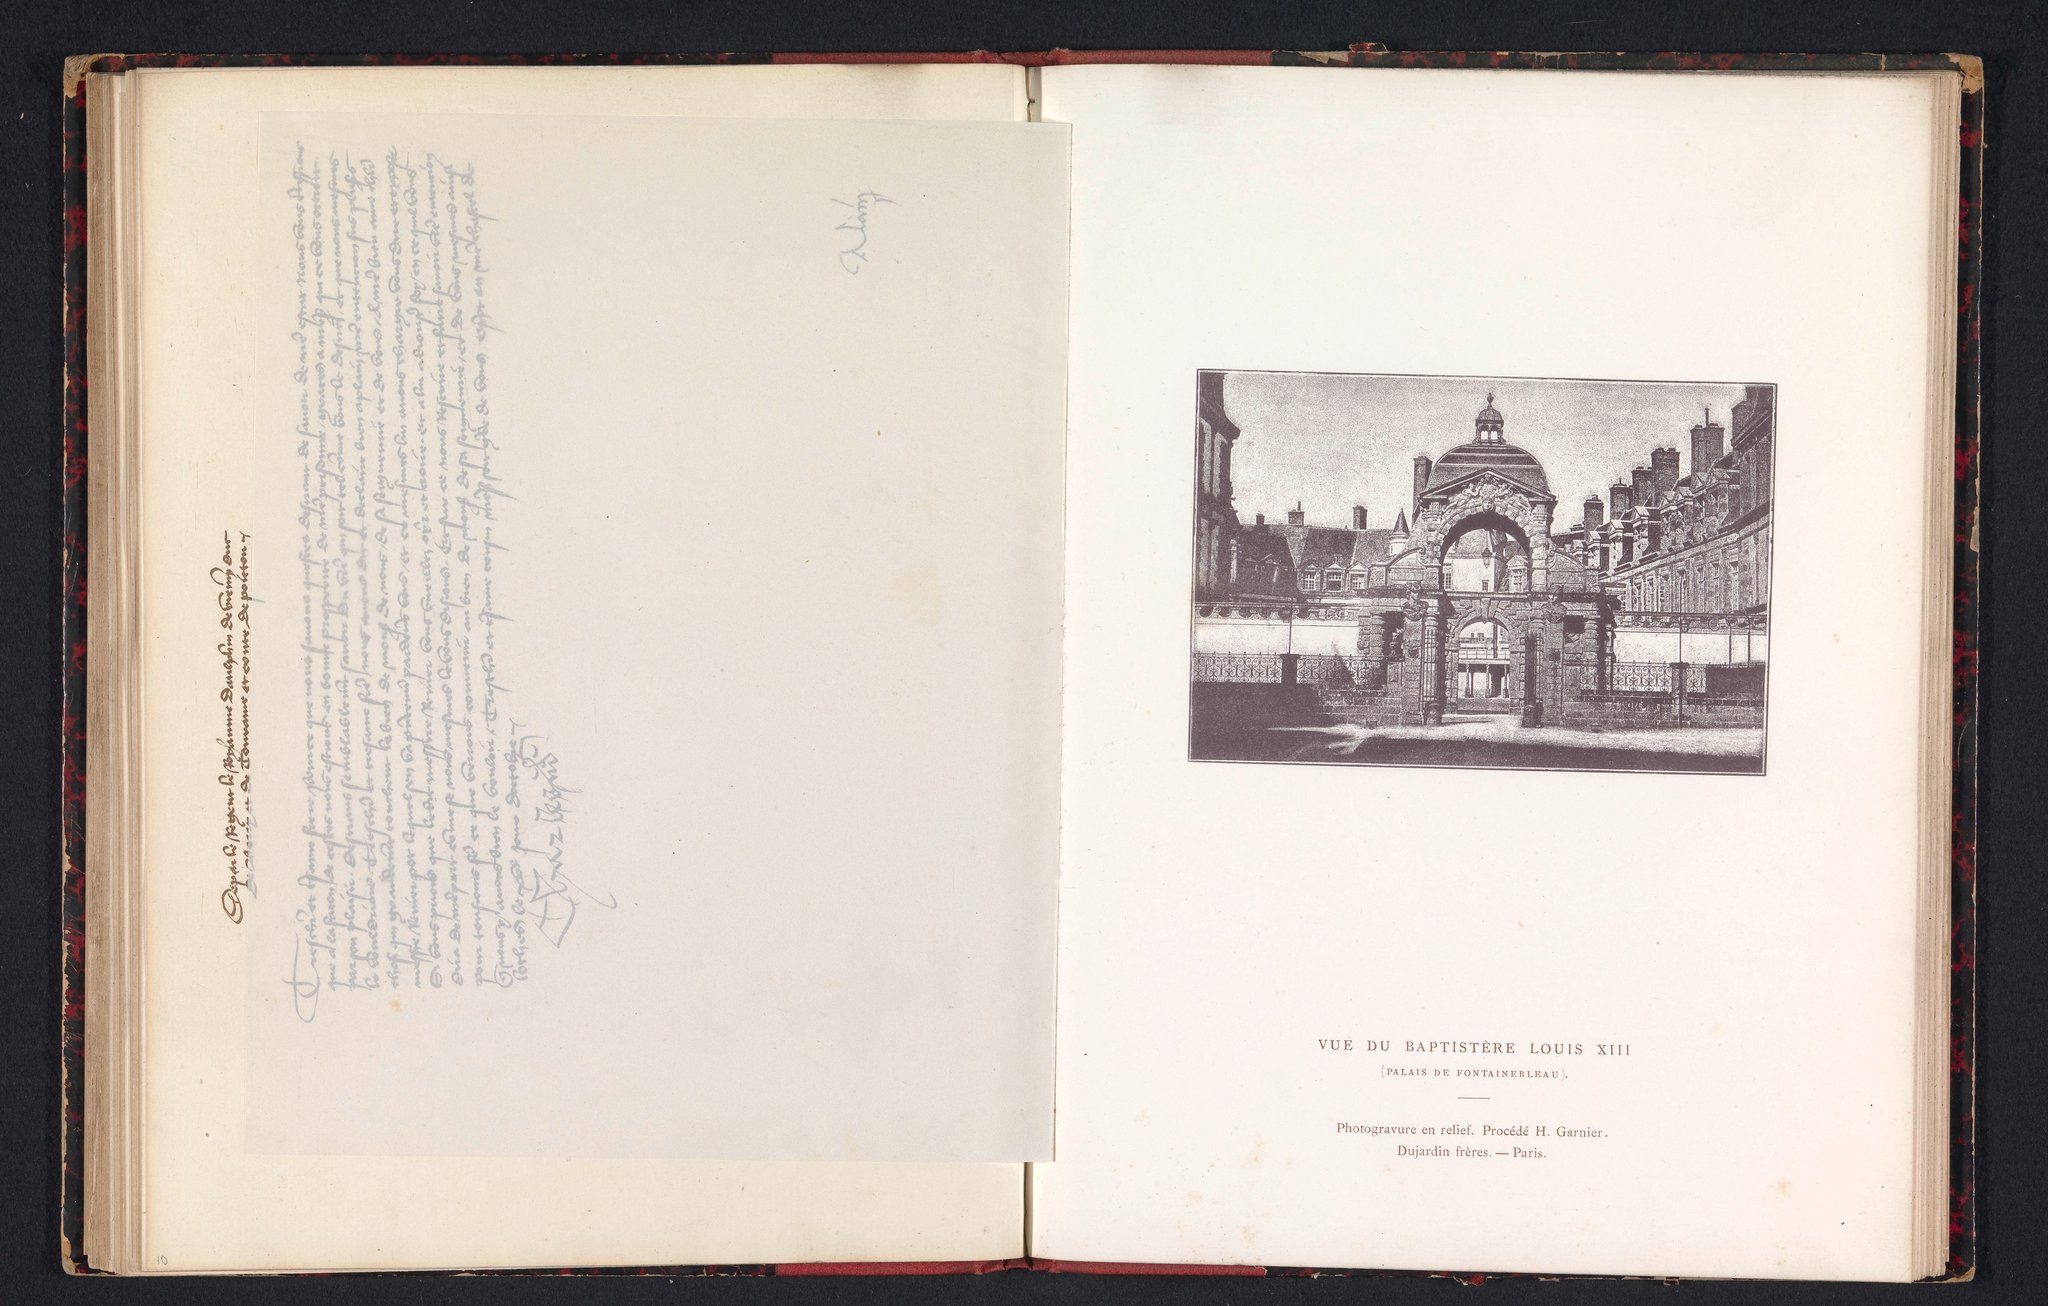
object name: photomechanical print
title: Gezicht op de toegangspoort van het kasteel van Fontainebleau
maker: Anonymous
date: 1859-1869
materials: paper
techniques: photoaquatint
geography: fontainebleau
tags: gate, entrance, façade (of house or building)